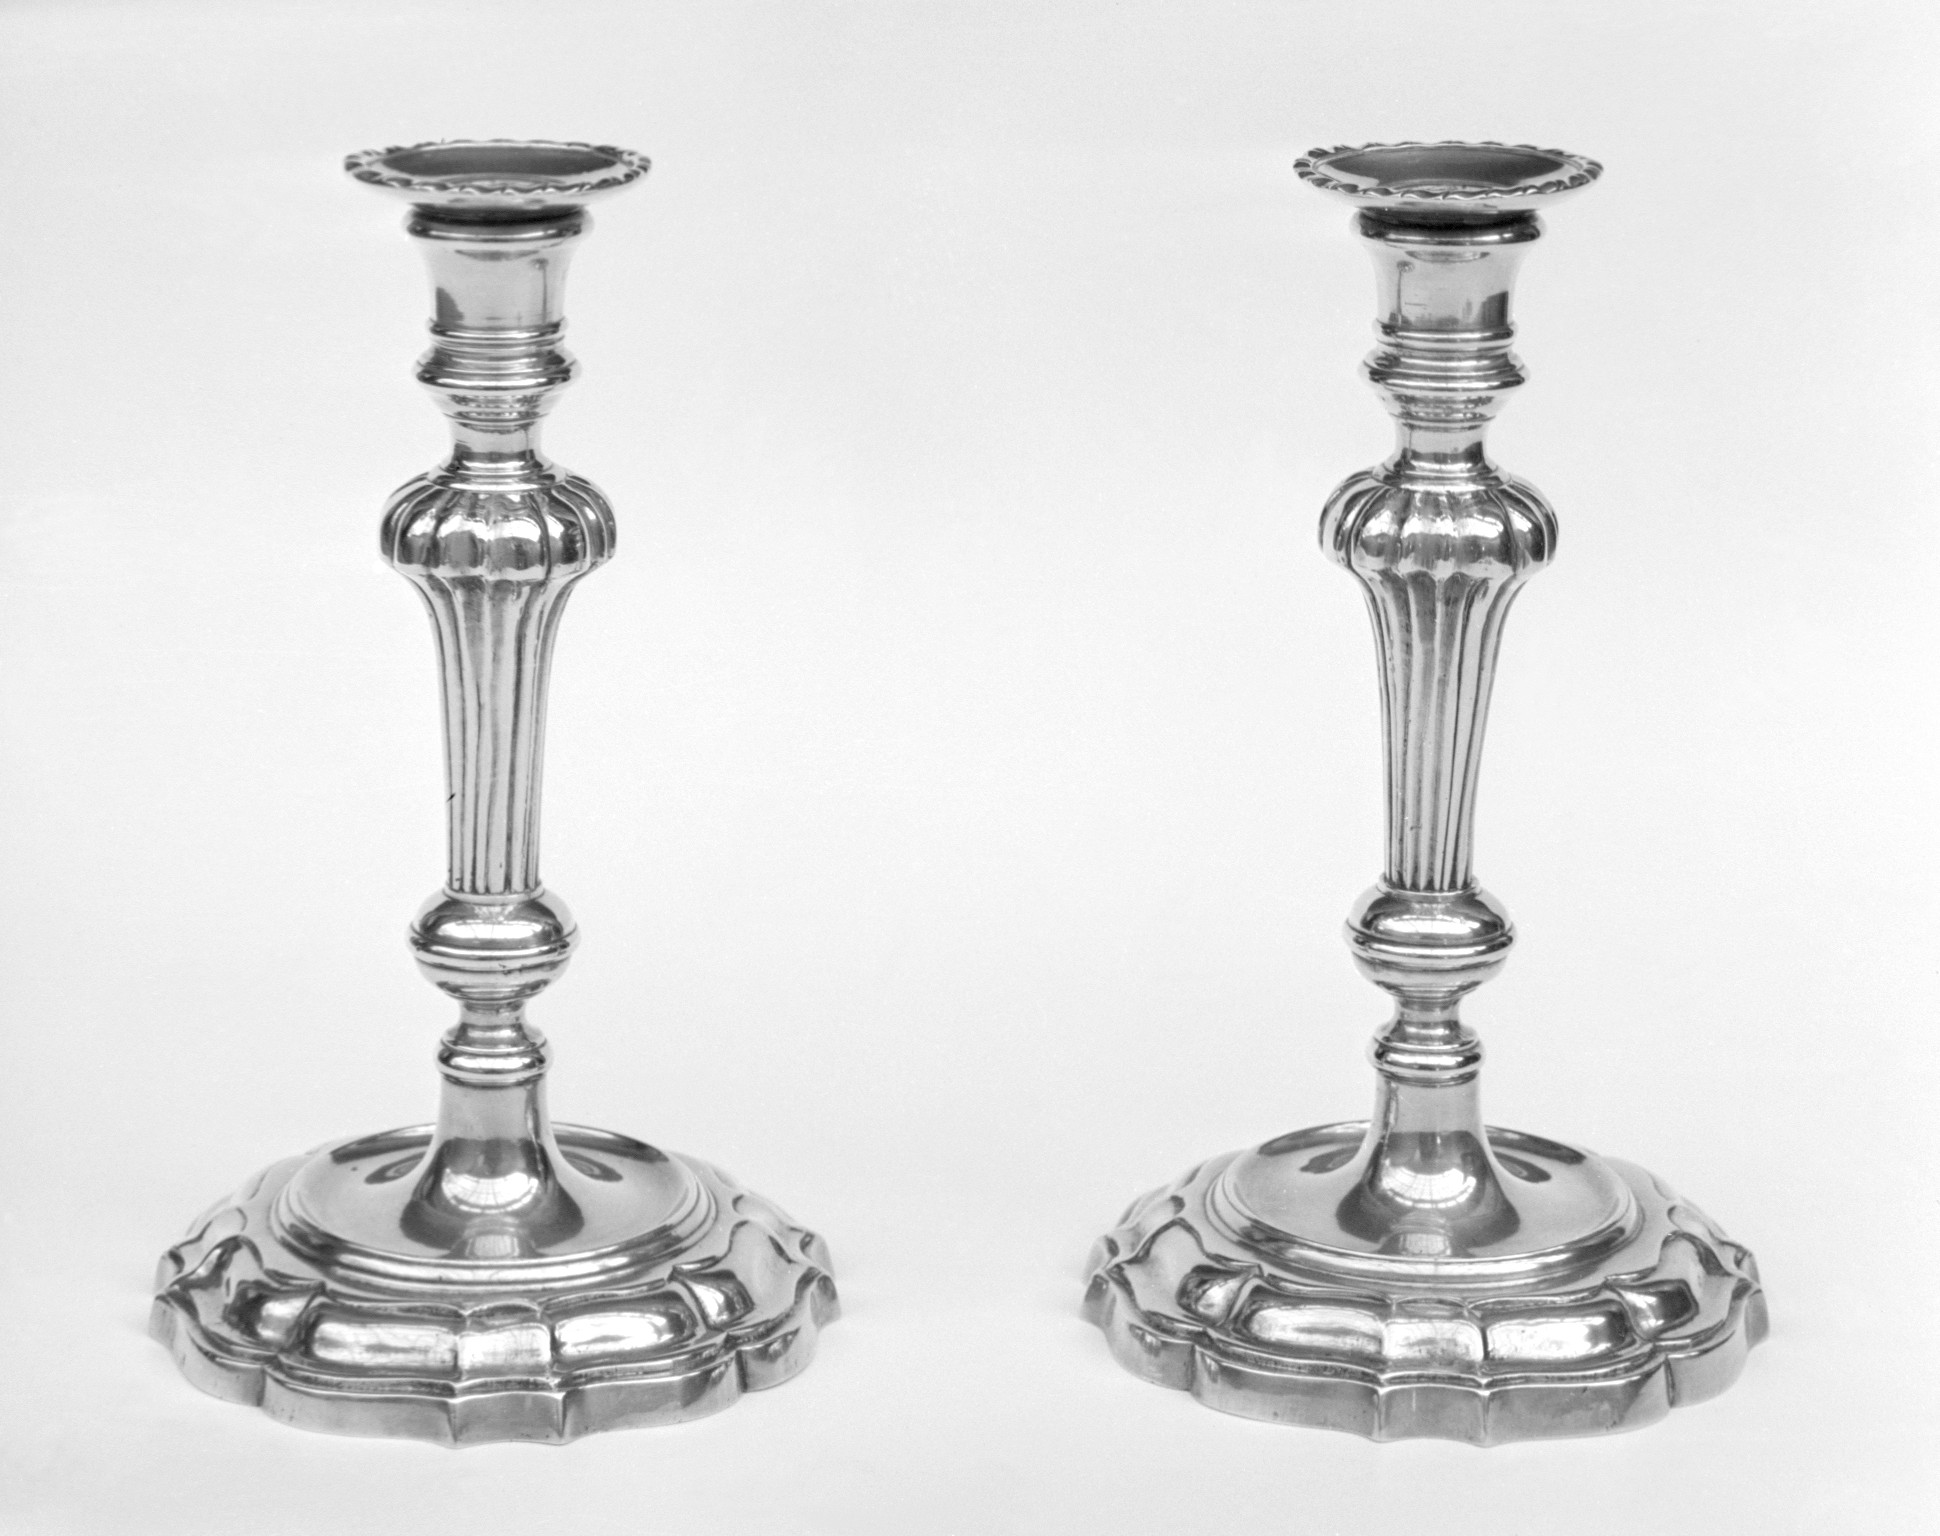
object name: candlestick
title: Pair of candlesticks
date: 1701-1800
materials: brass